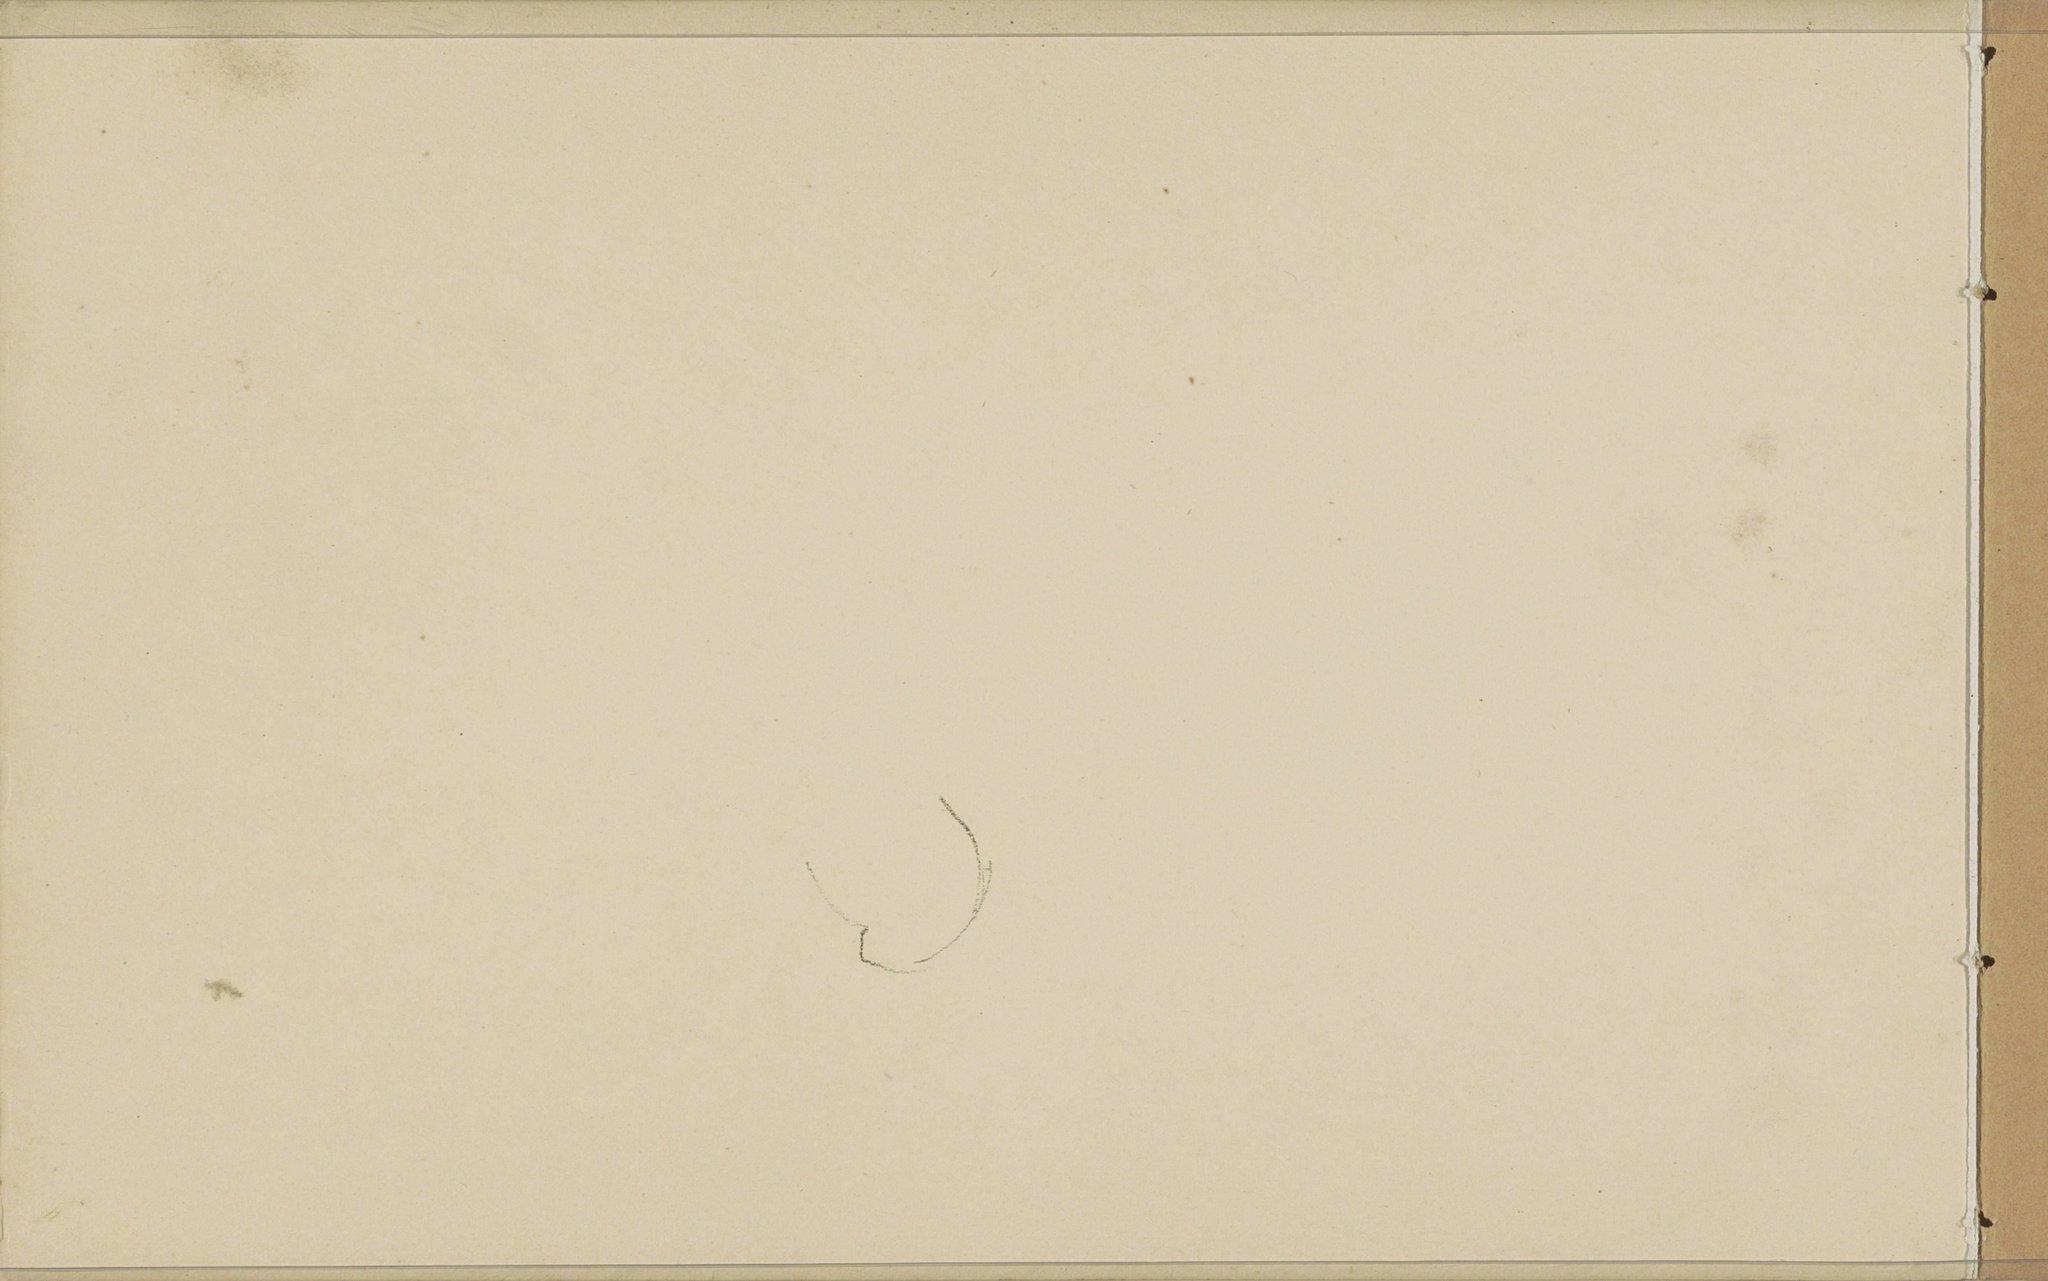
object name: sketchbook leaf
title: Studie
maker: a.a.l. de grammont-hubrecht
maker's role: draughtsman, painter, print maker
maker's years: 1855-1913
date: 1865-1913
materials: chalk, paper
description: Blad 58 verso uit een schetsboek met 65 bladen.